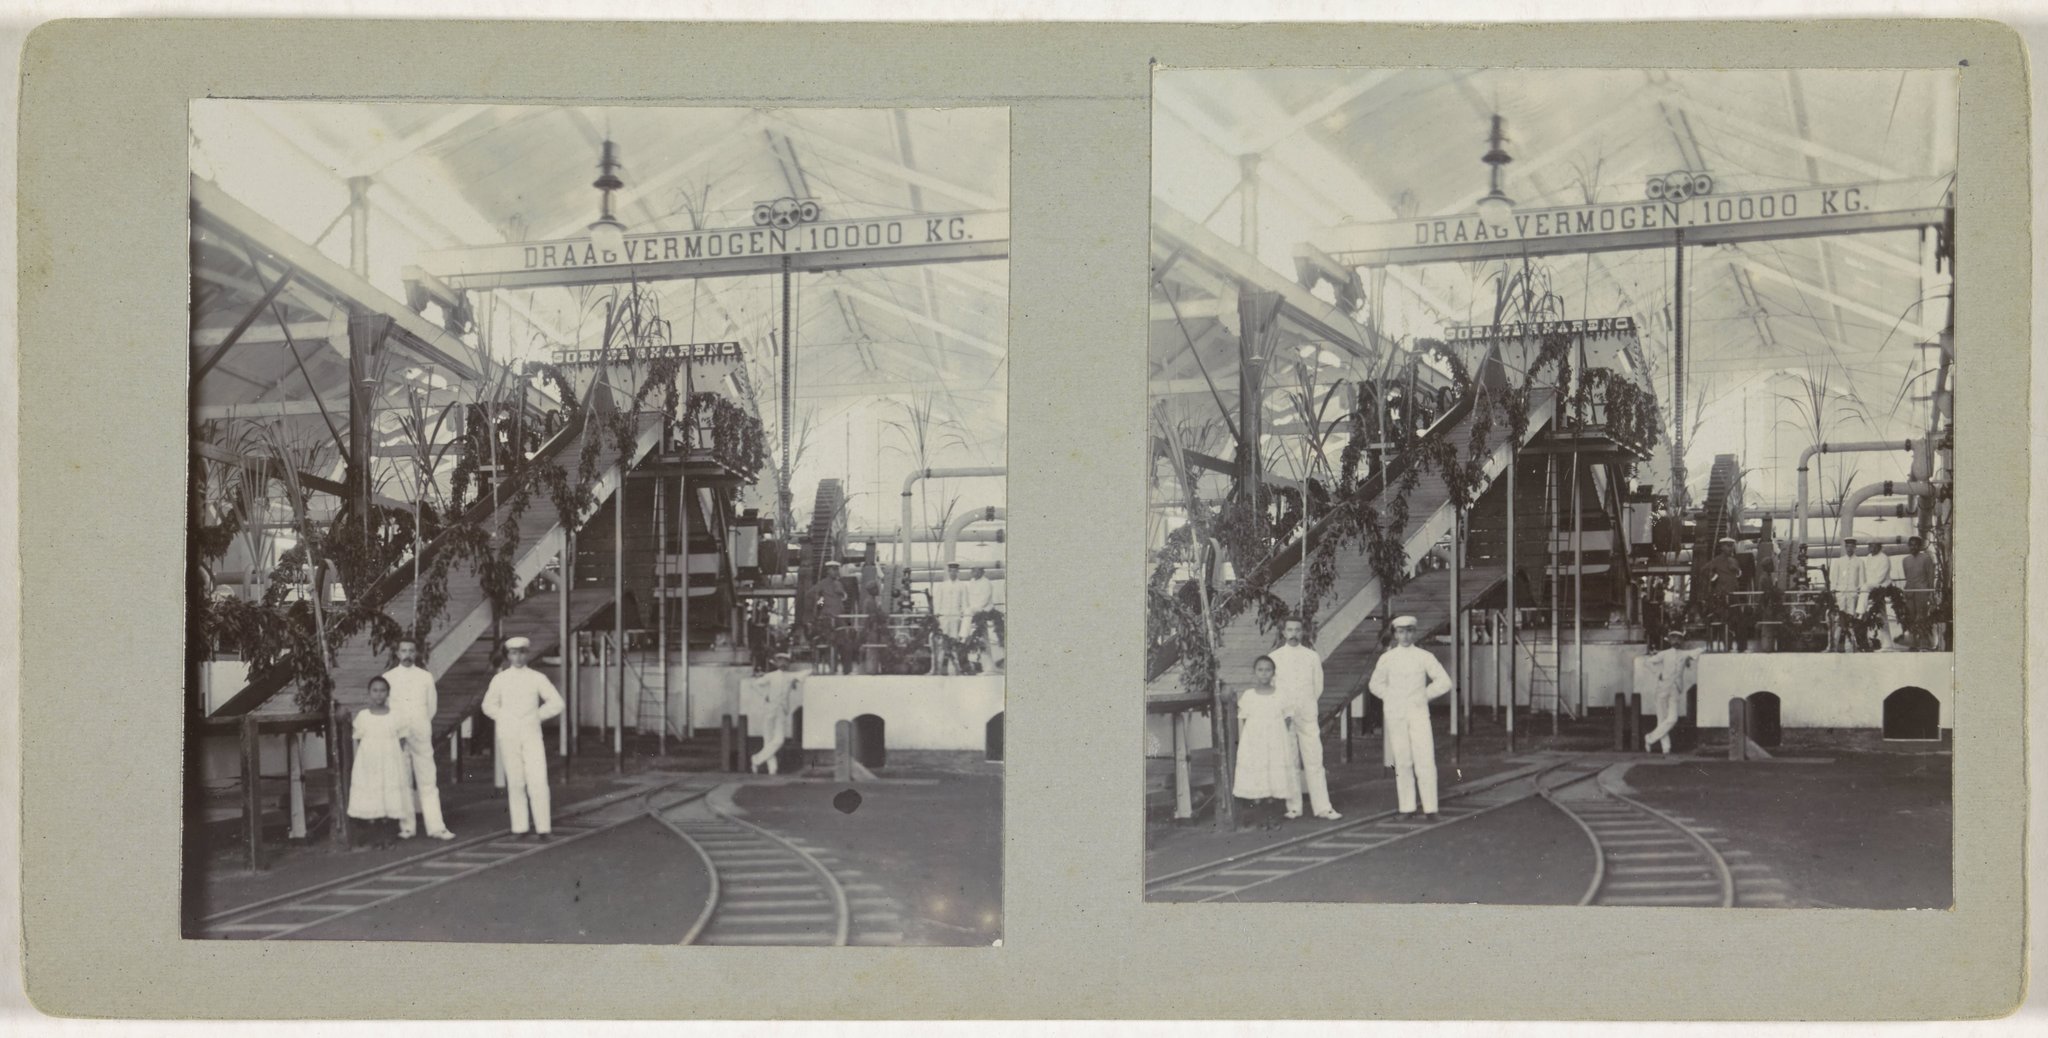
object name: stereograph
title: Mensen poserend in suikerfabriek (?) Soemberkareng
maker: Anonymous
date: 1906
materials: cardboard, paper, photographic support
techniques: albumen print